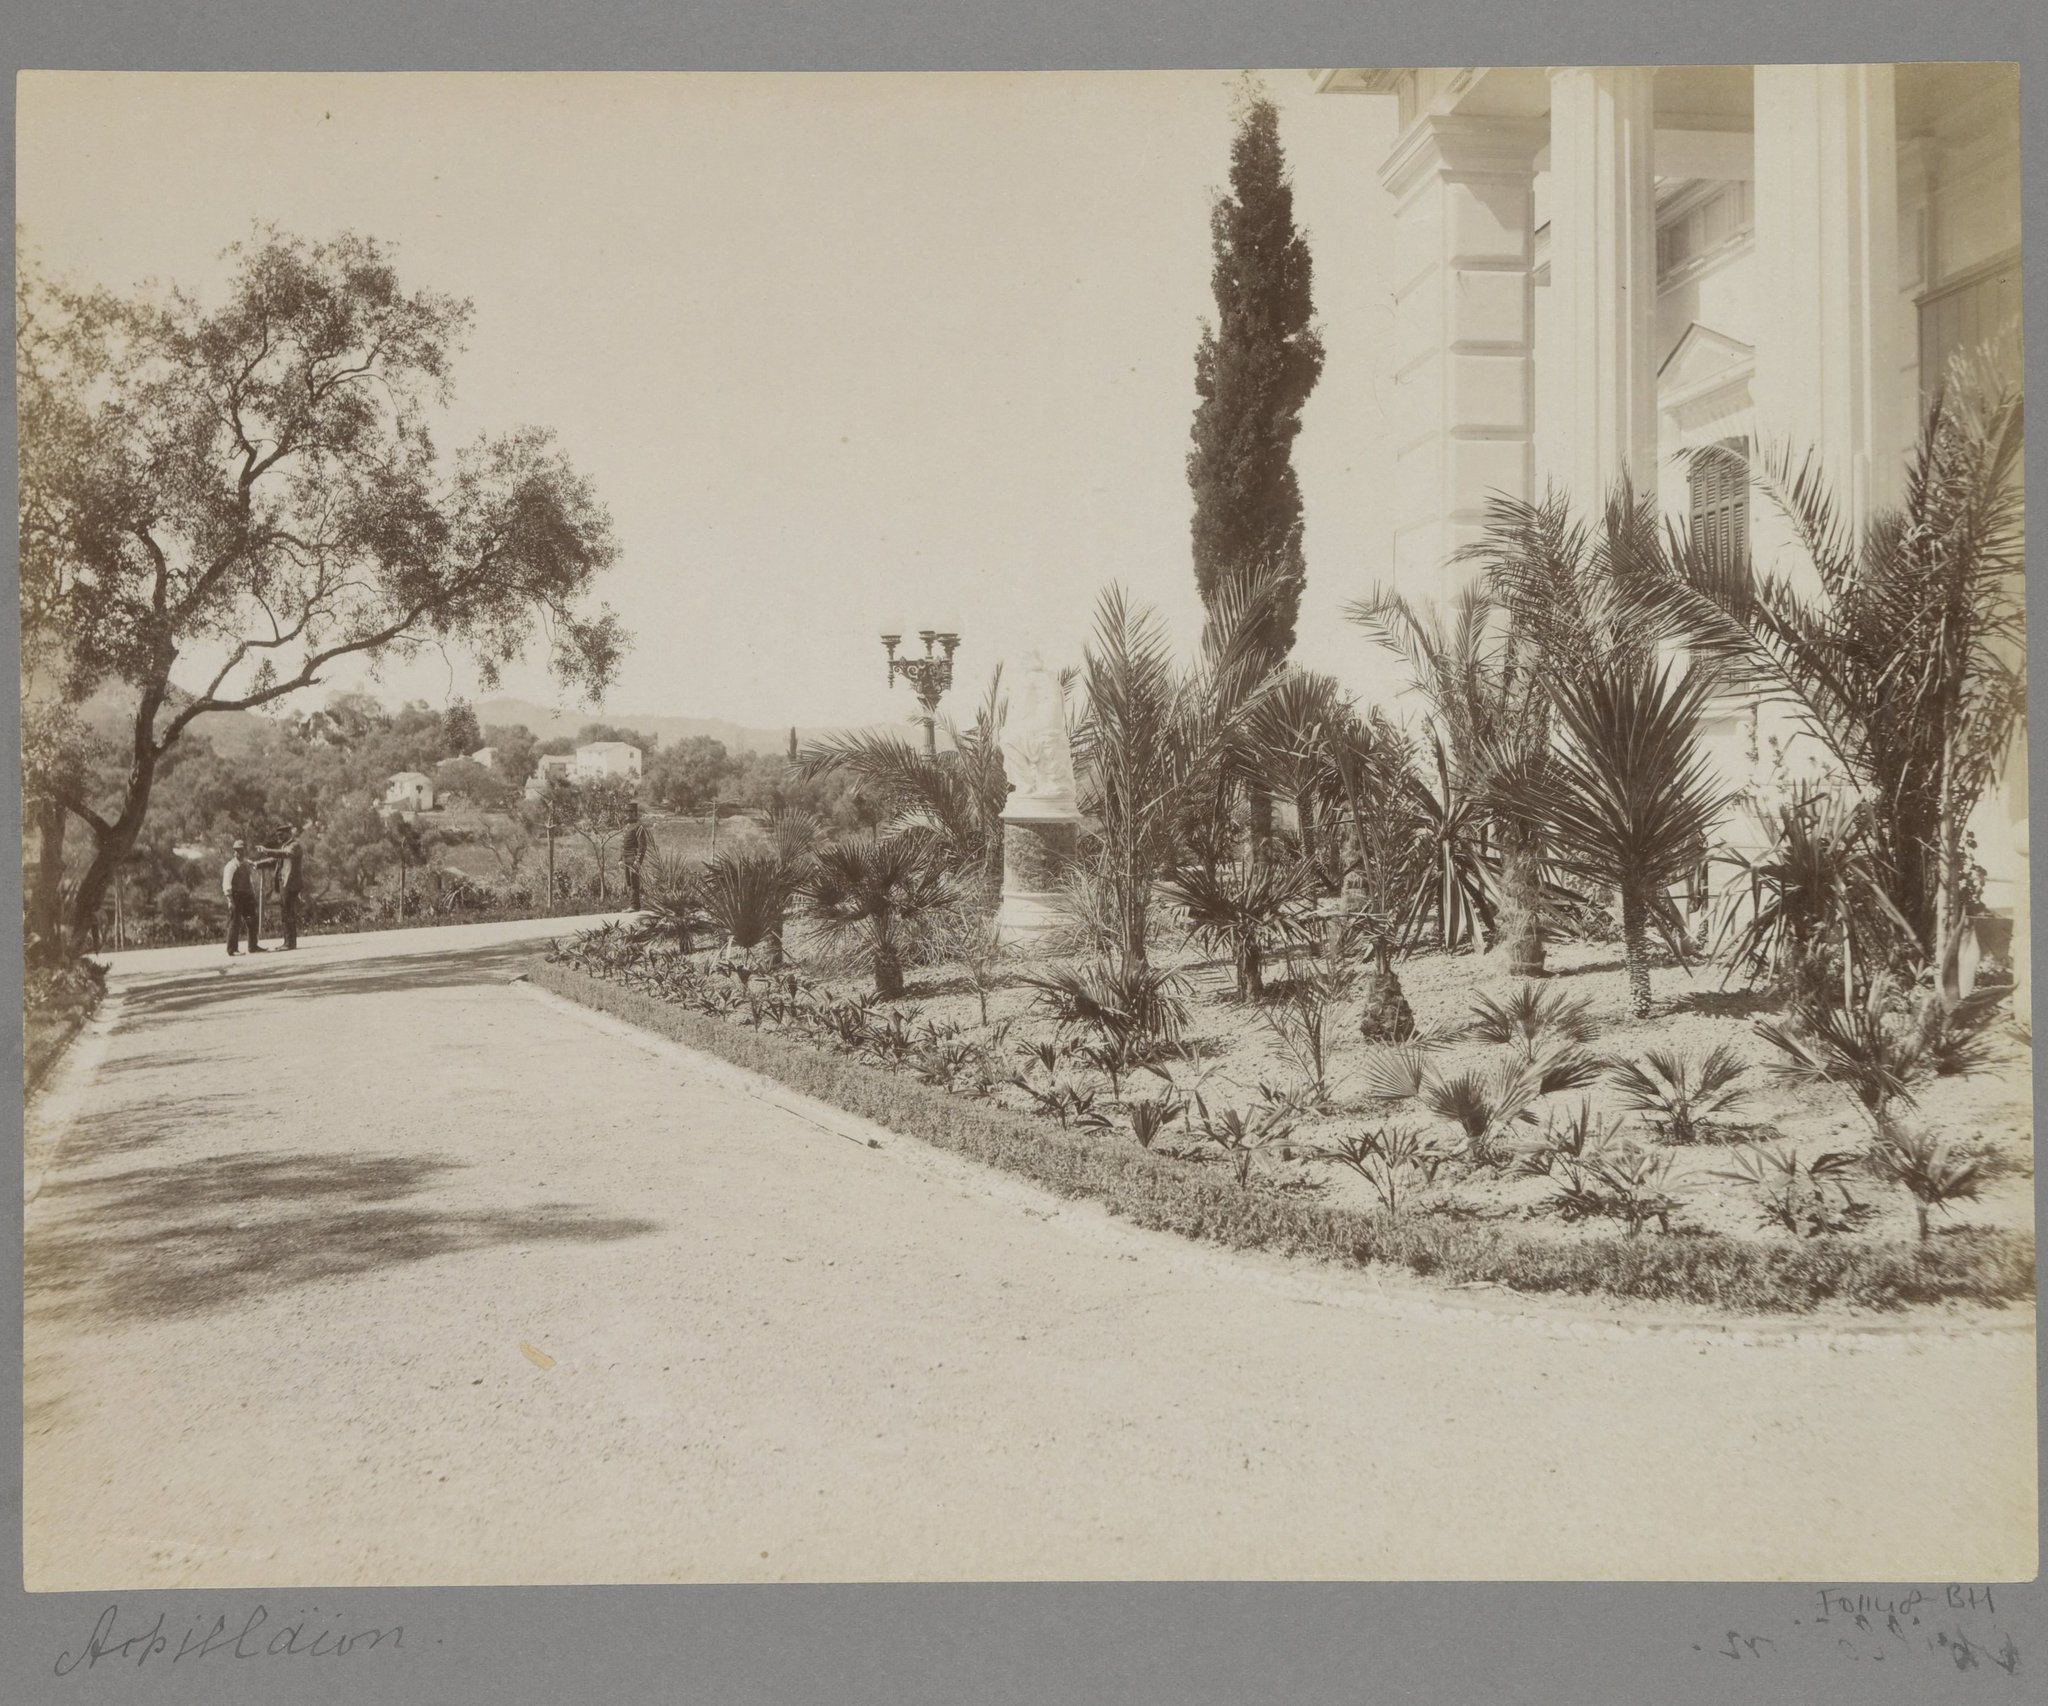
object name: photograph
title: Tuin van het Achilleion op Corfu met beelden en mannen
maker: Anonymous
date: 1895-1905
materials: paper, photographic support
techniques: albumen print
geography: corfu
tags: garden, piece of sculpture, reproduction of a piece of sculpture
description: Onderdeel van Reisalbum met foto's van bezienswaardigheden in Griekenland en Egypte.